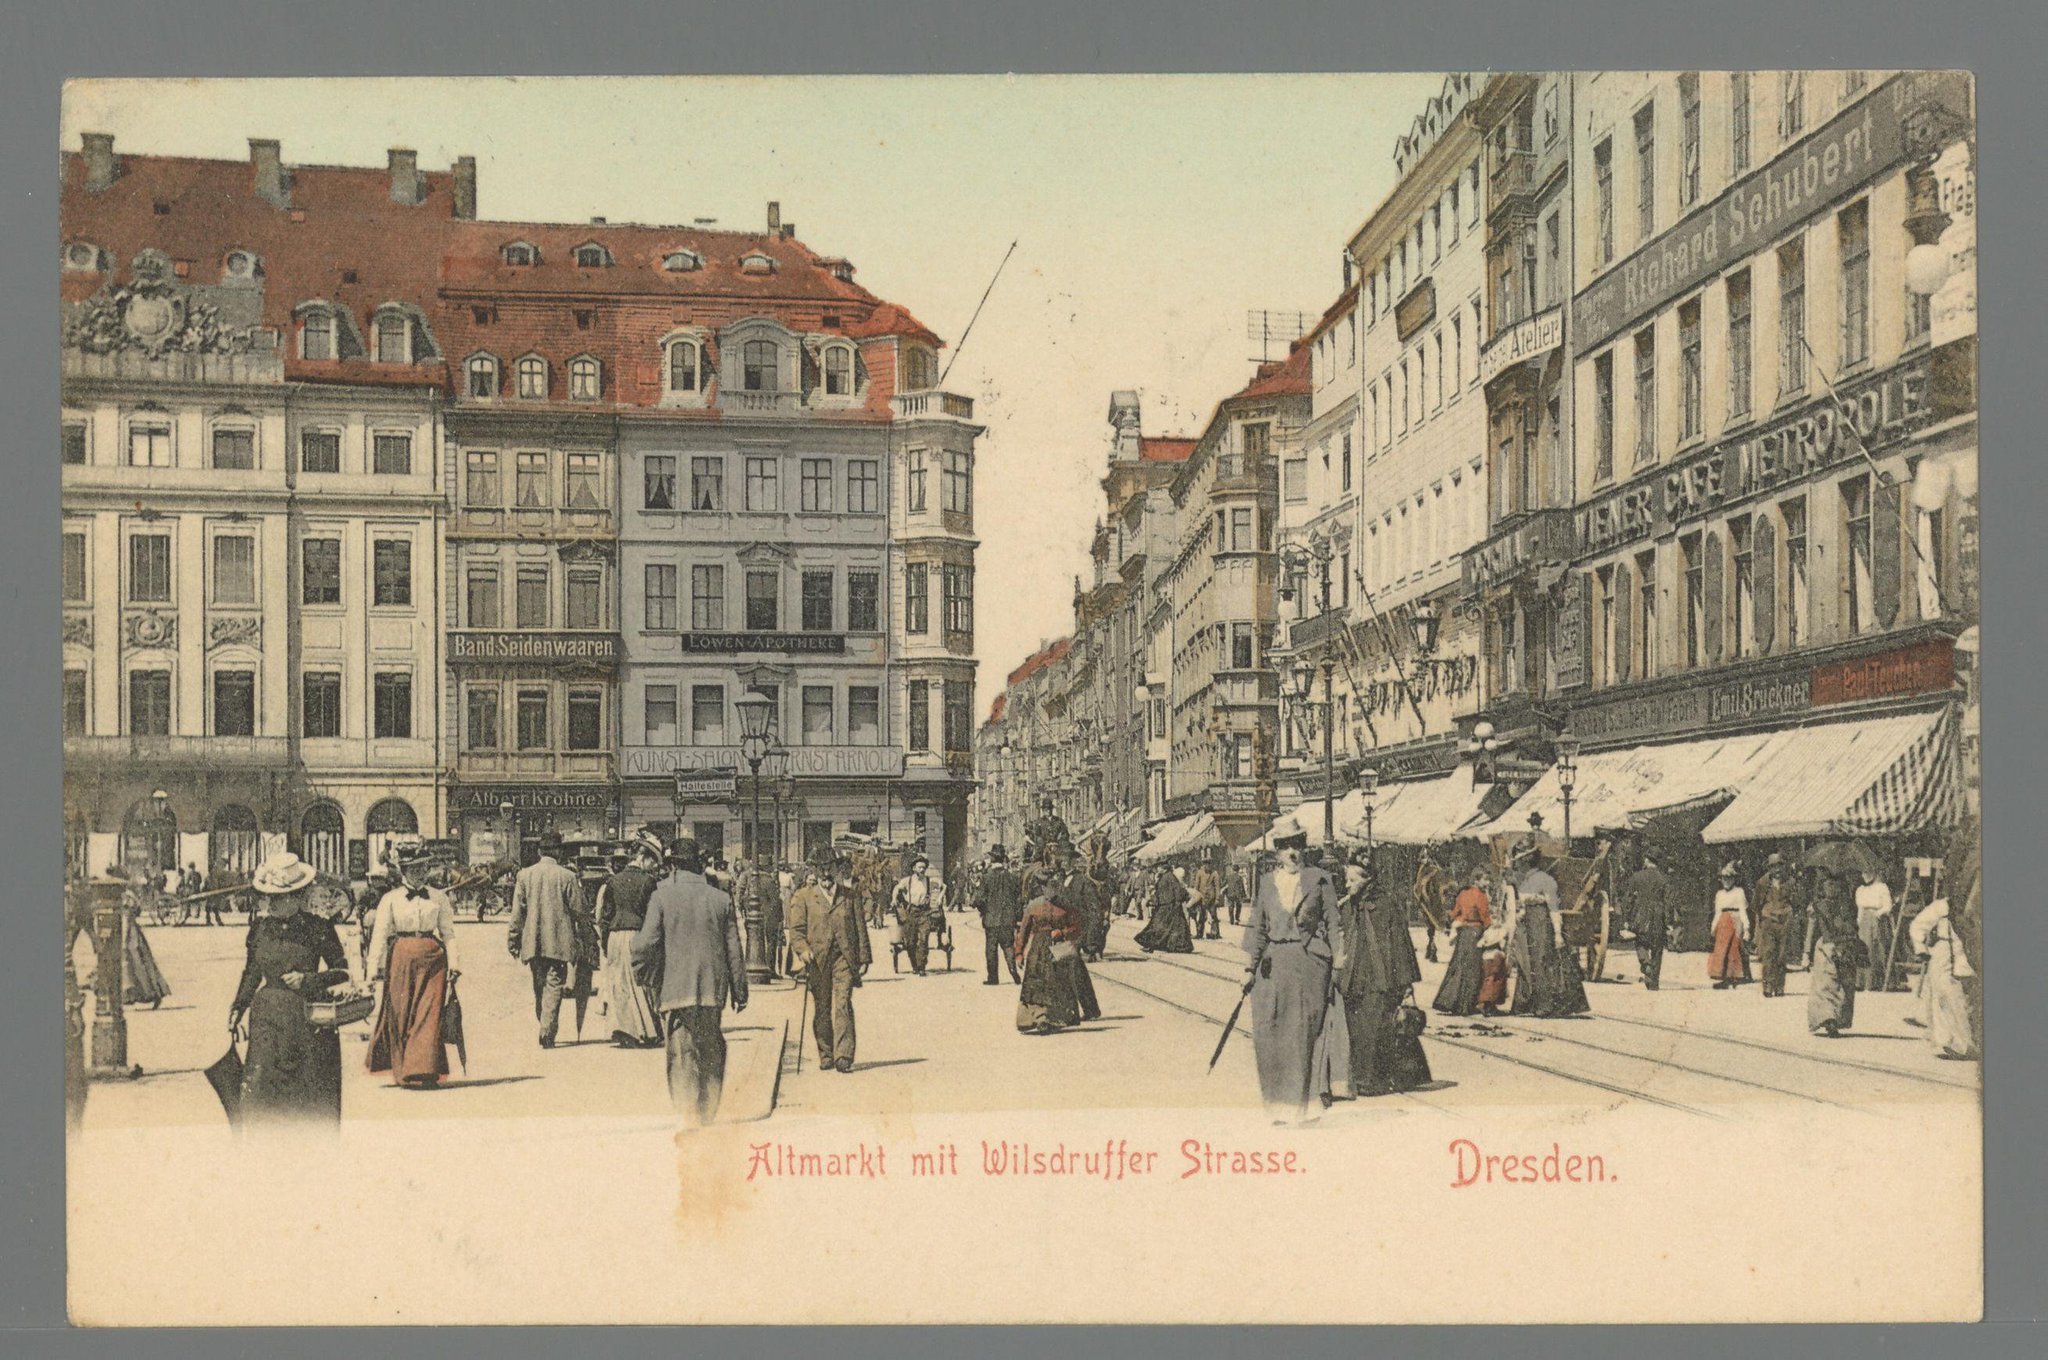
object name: photomechanical print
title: Altmarkt mit Wilsdruffer Strasse. Dresden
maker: Anonymous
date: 1885-1903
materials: cardboard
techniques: photograph, lithograph, writing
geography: dresden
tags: square, place, circus, etc., street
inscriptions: postage stamp